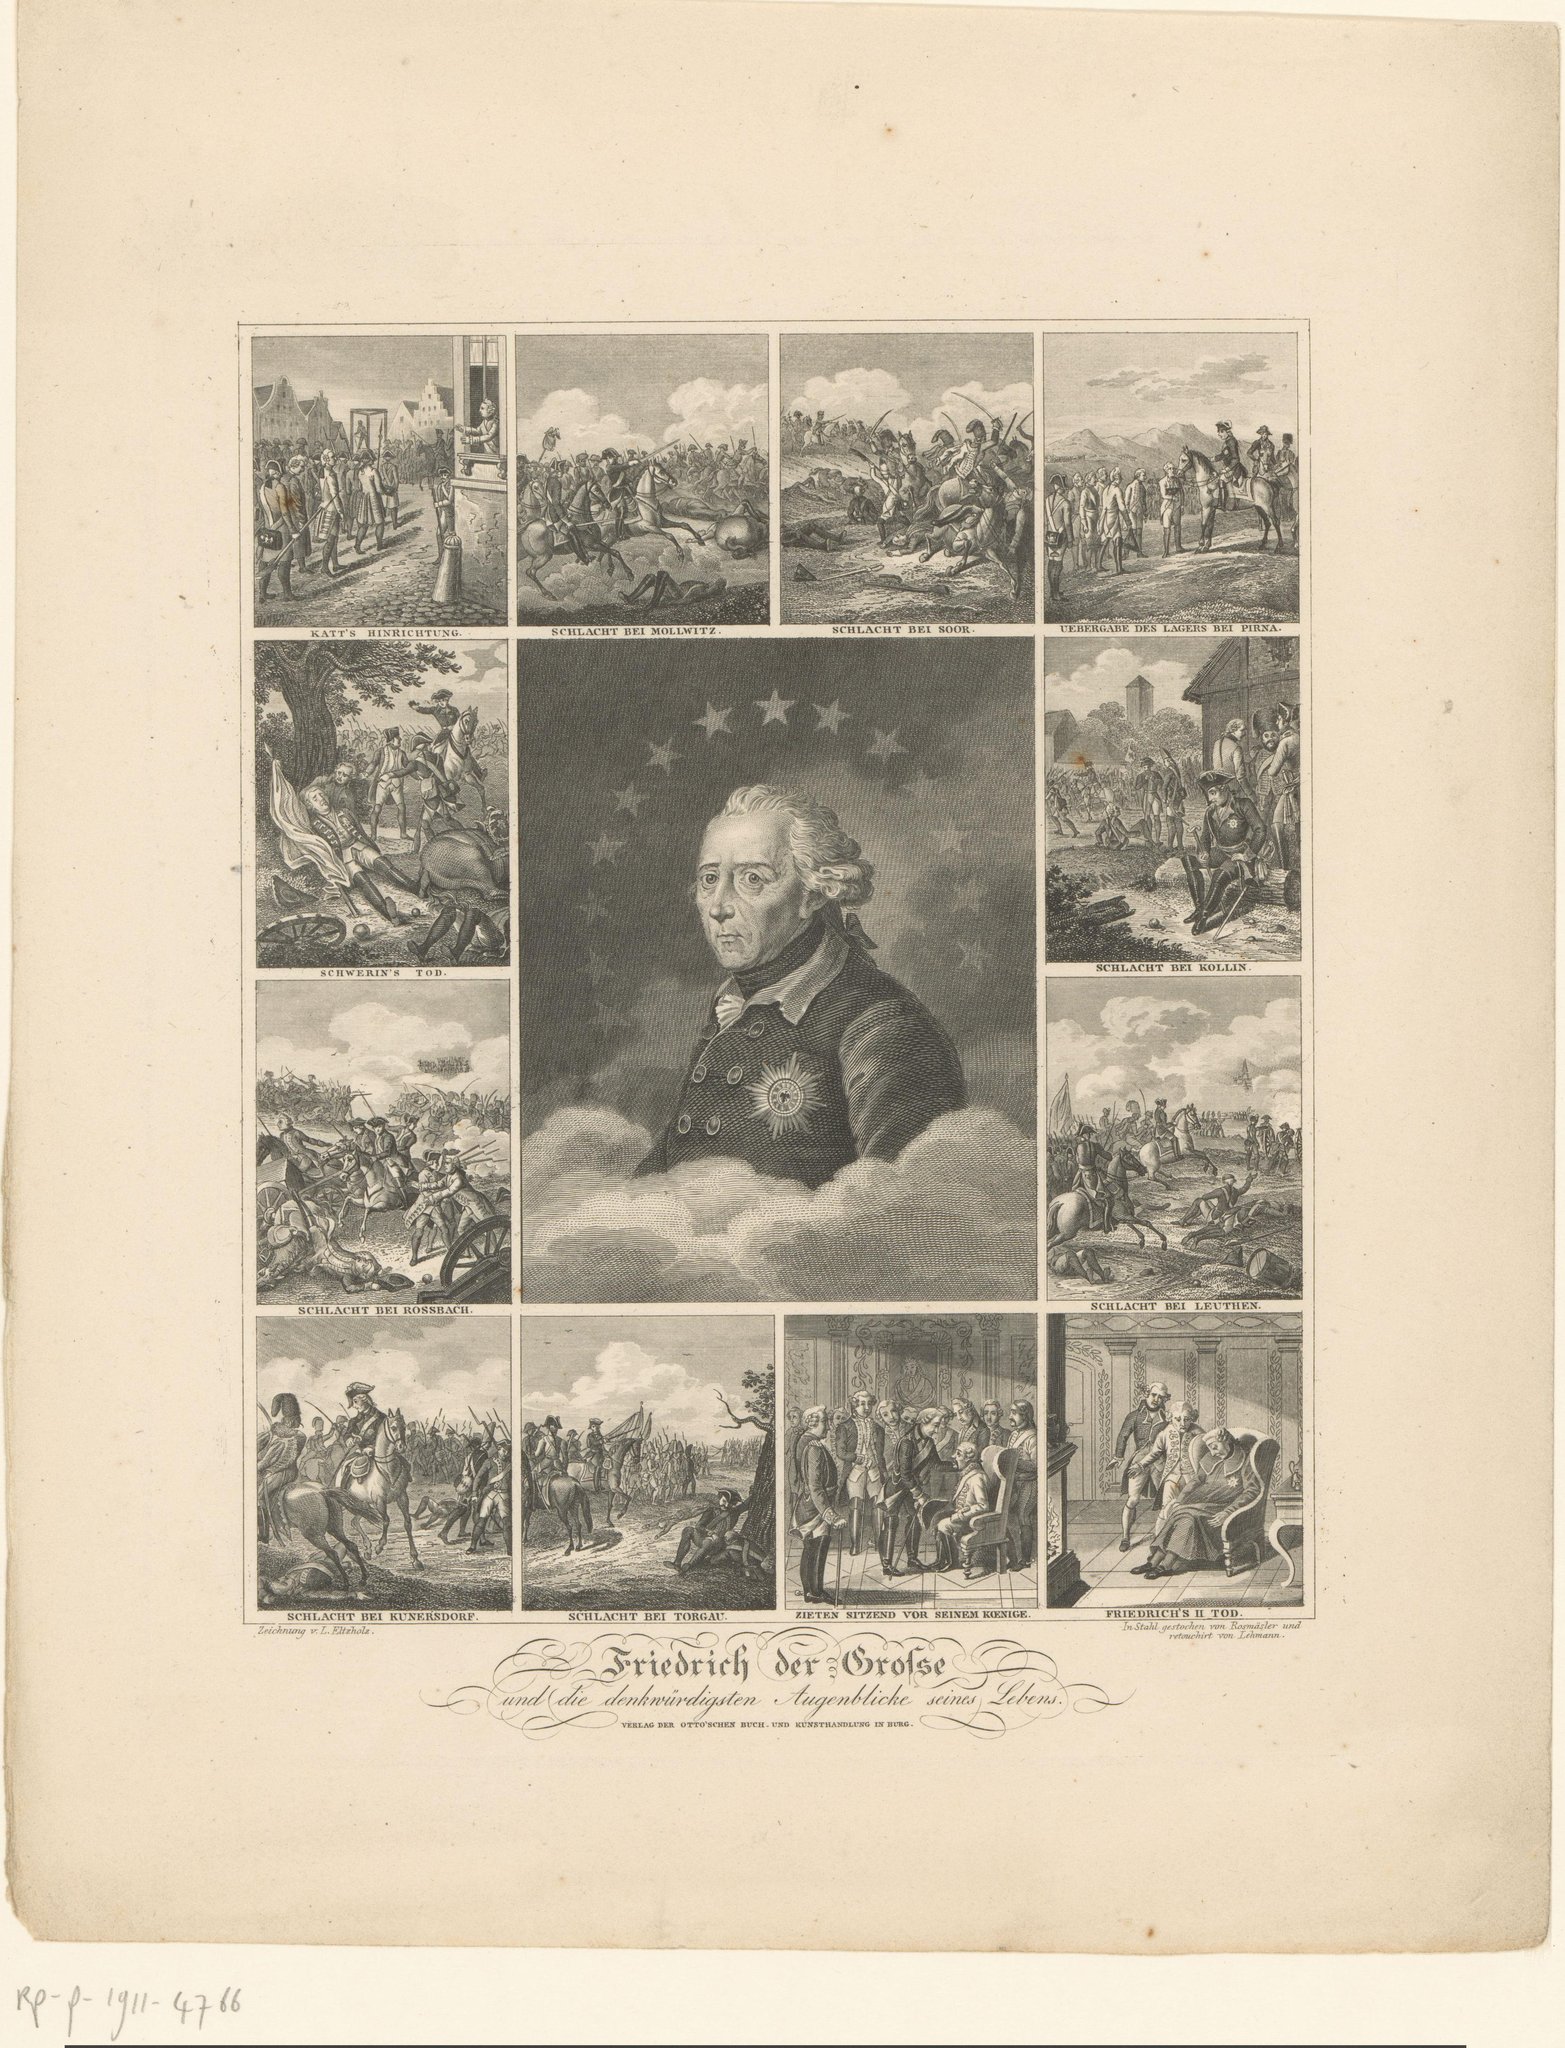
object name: print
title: Portret van Frederik de Grote met diverse levensgebeurtenissen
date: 1785-1858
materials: paper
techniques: engraving, etching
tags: berlin, frederick ii (king of prussia), historical persons, historical persons (portraits and scenes from the life)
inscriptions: collector's mark: Lugt 2228